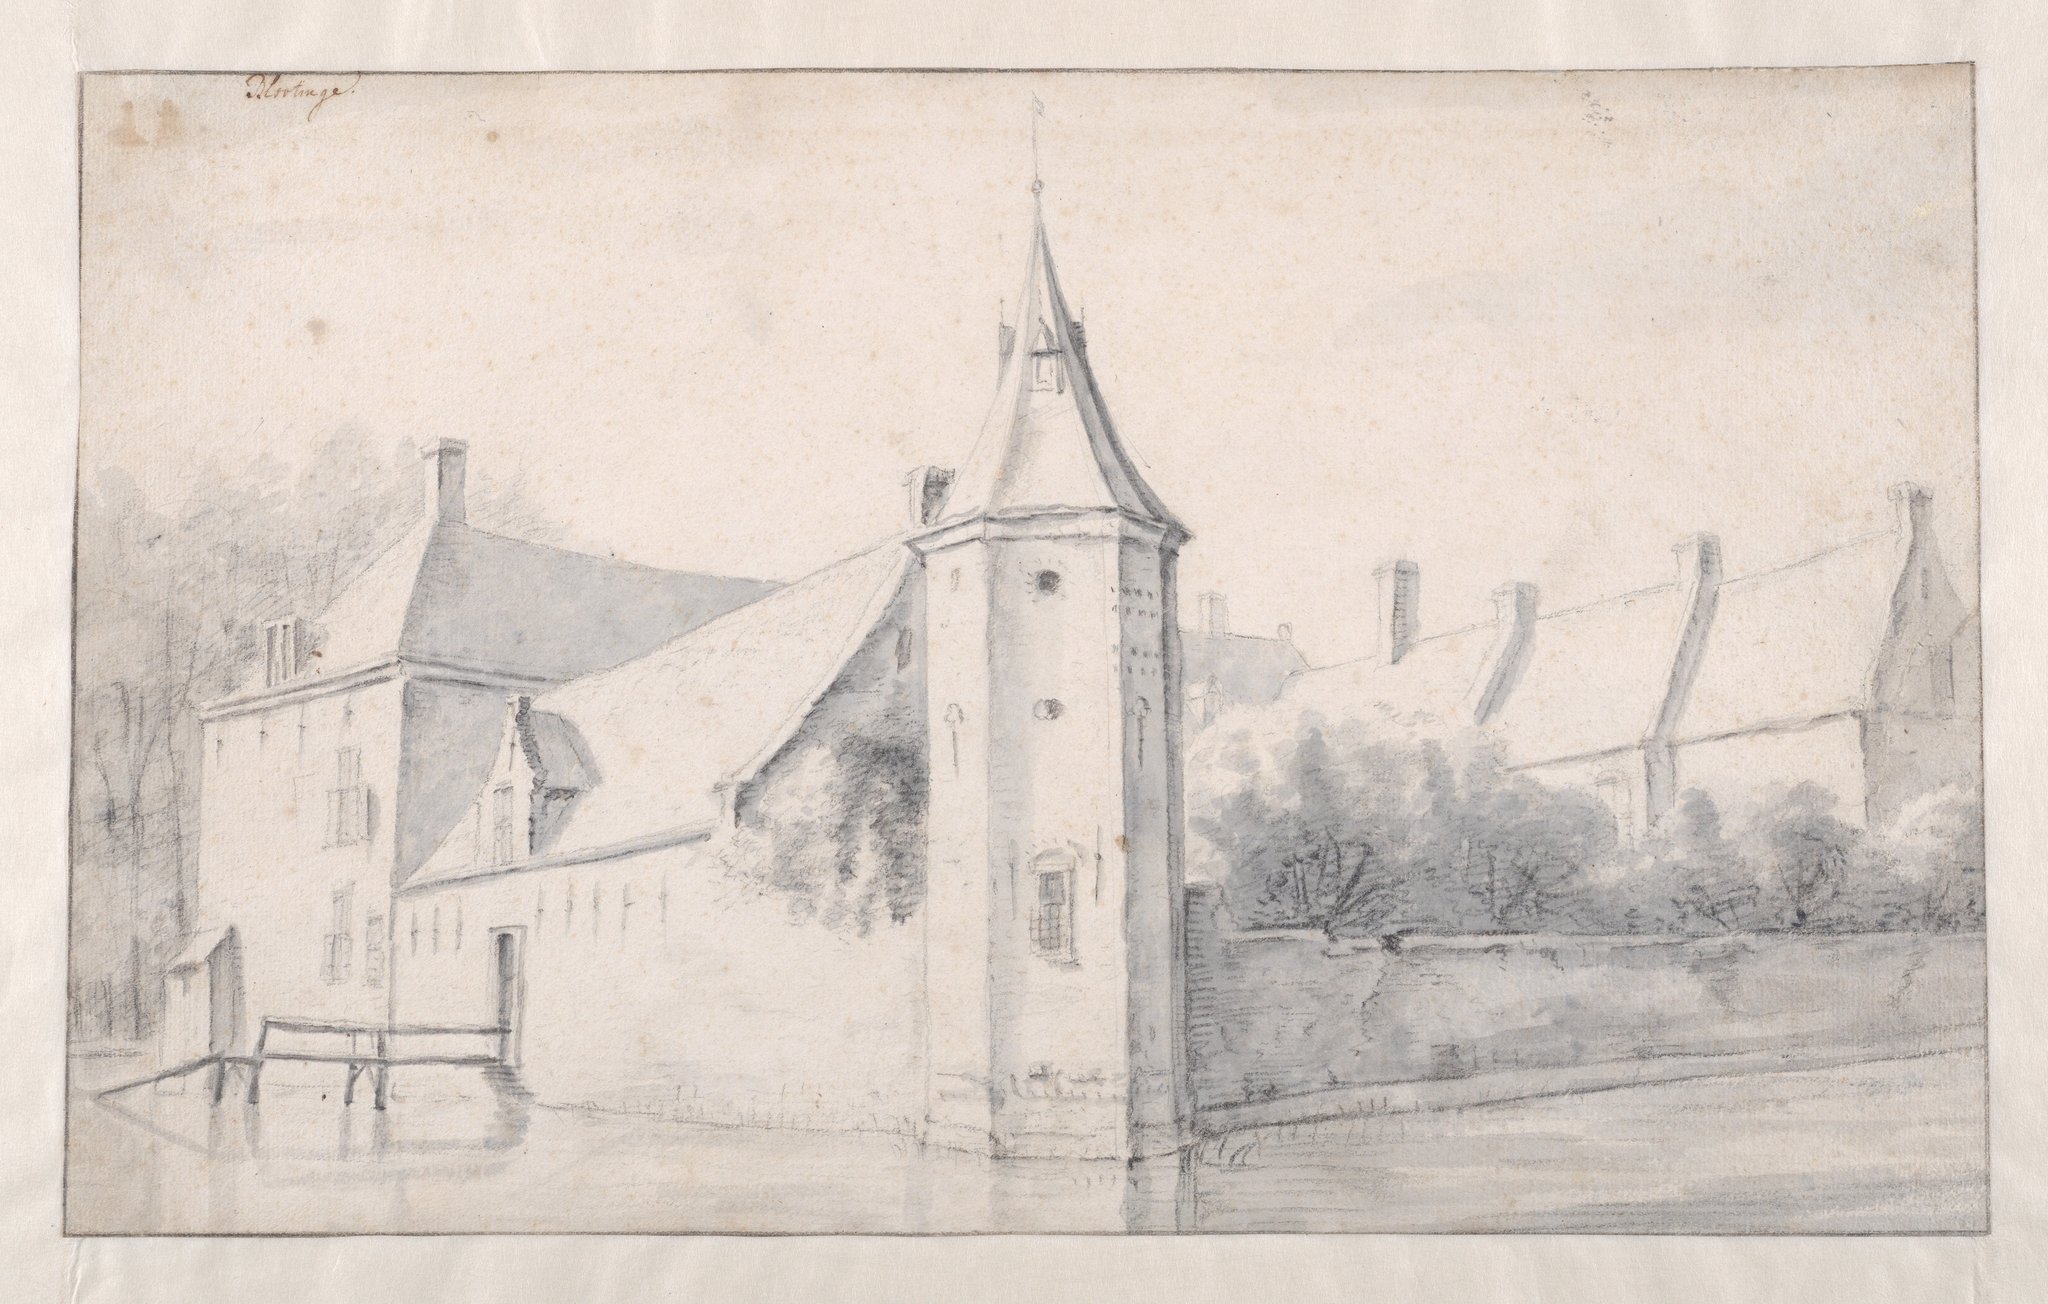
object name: drawing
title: View of Castle Te Blotinghe, near The Hague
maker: roelant roghman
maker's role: artist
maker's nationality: dutch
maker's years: 1627-1692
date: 1646-1692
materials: chalk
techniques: brush, wash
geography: netherlands